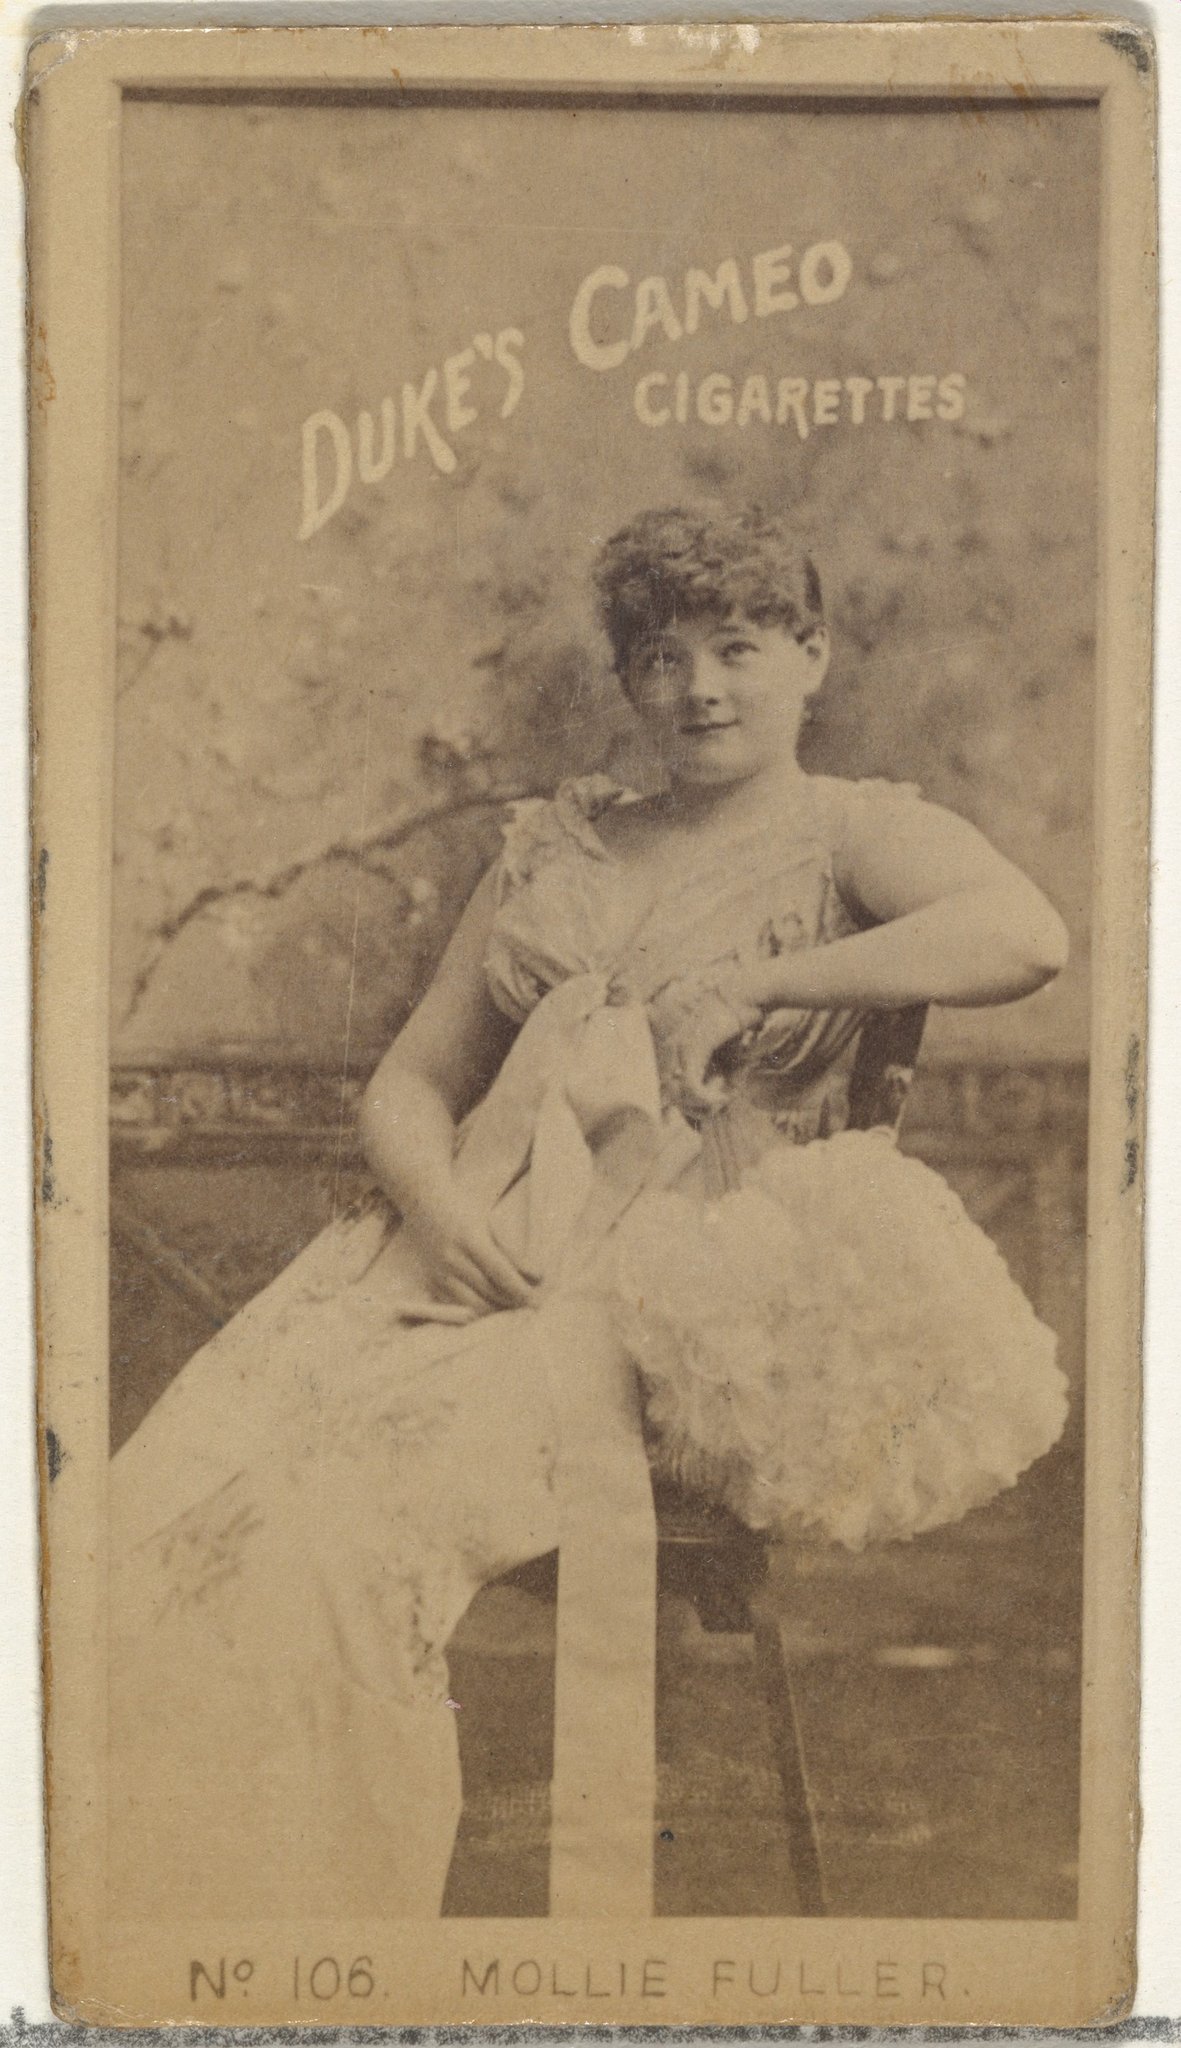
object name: photograph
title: Card Number 107, Mollie Fuller, from the Actors and Actresses series (N145-4) issued by Duke Sons & Co. to promote Cameo Cigarettes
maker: w. duke, sons & co.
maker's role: publisher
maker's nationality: american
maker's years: 1870-1920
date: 1880-1889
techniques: albumen silver print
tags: portraits,women,actresses